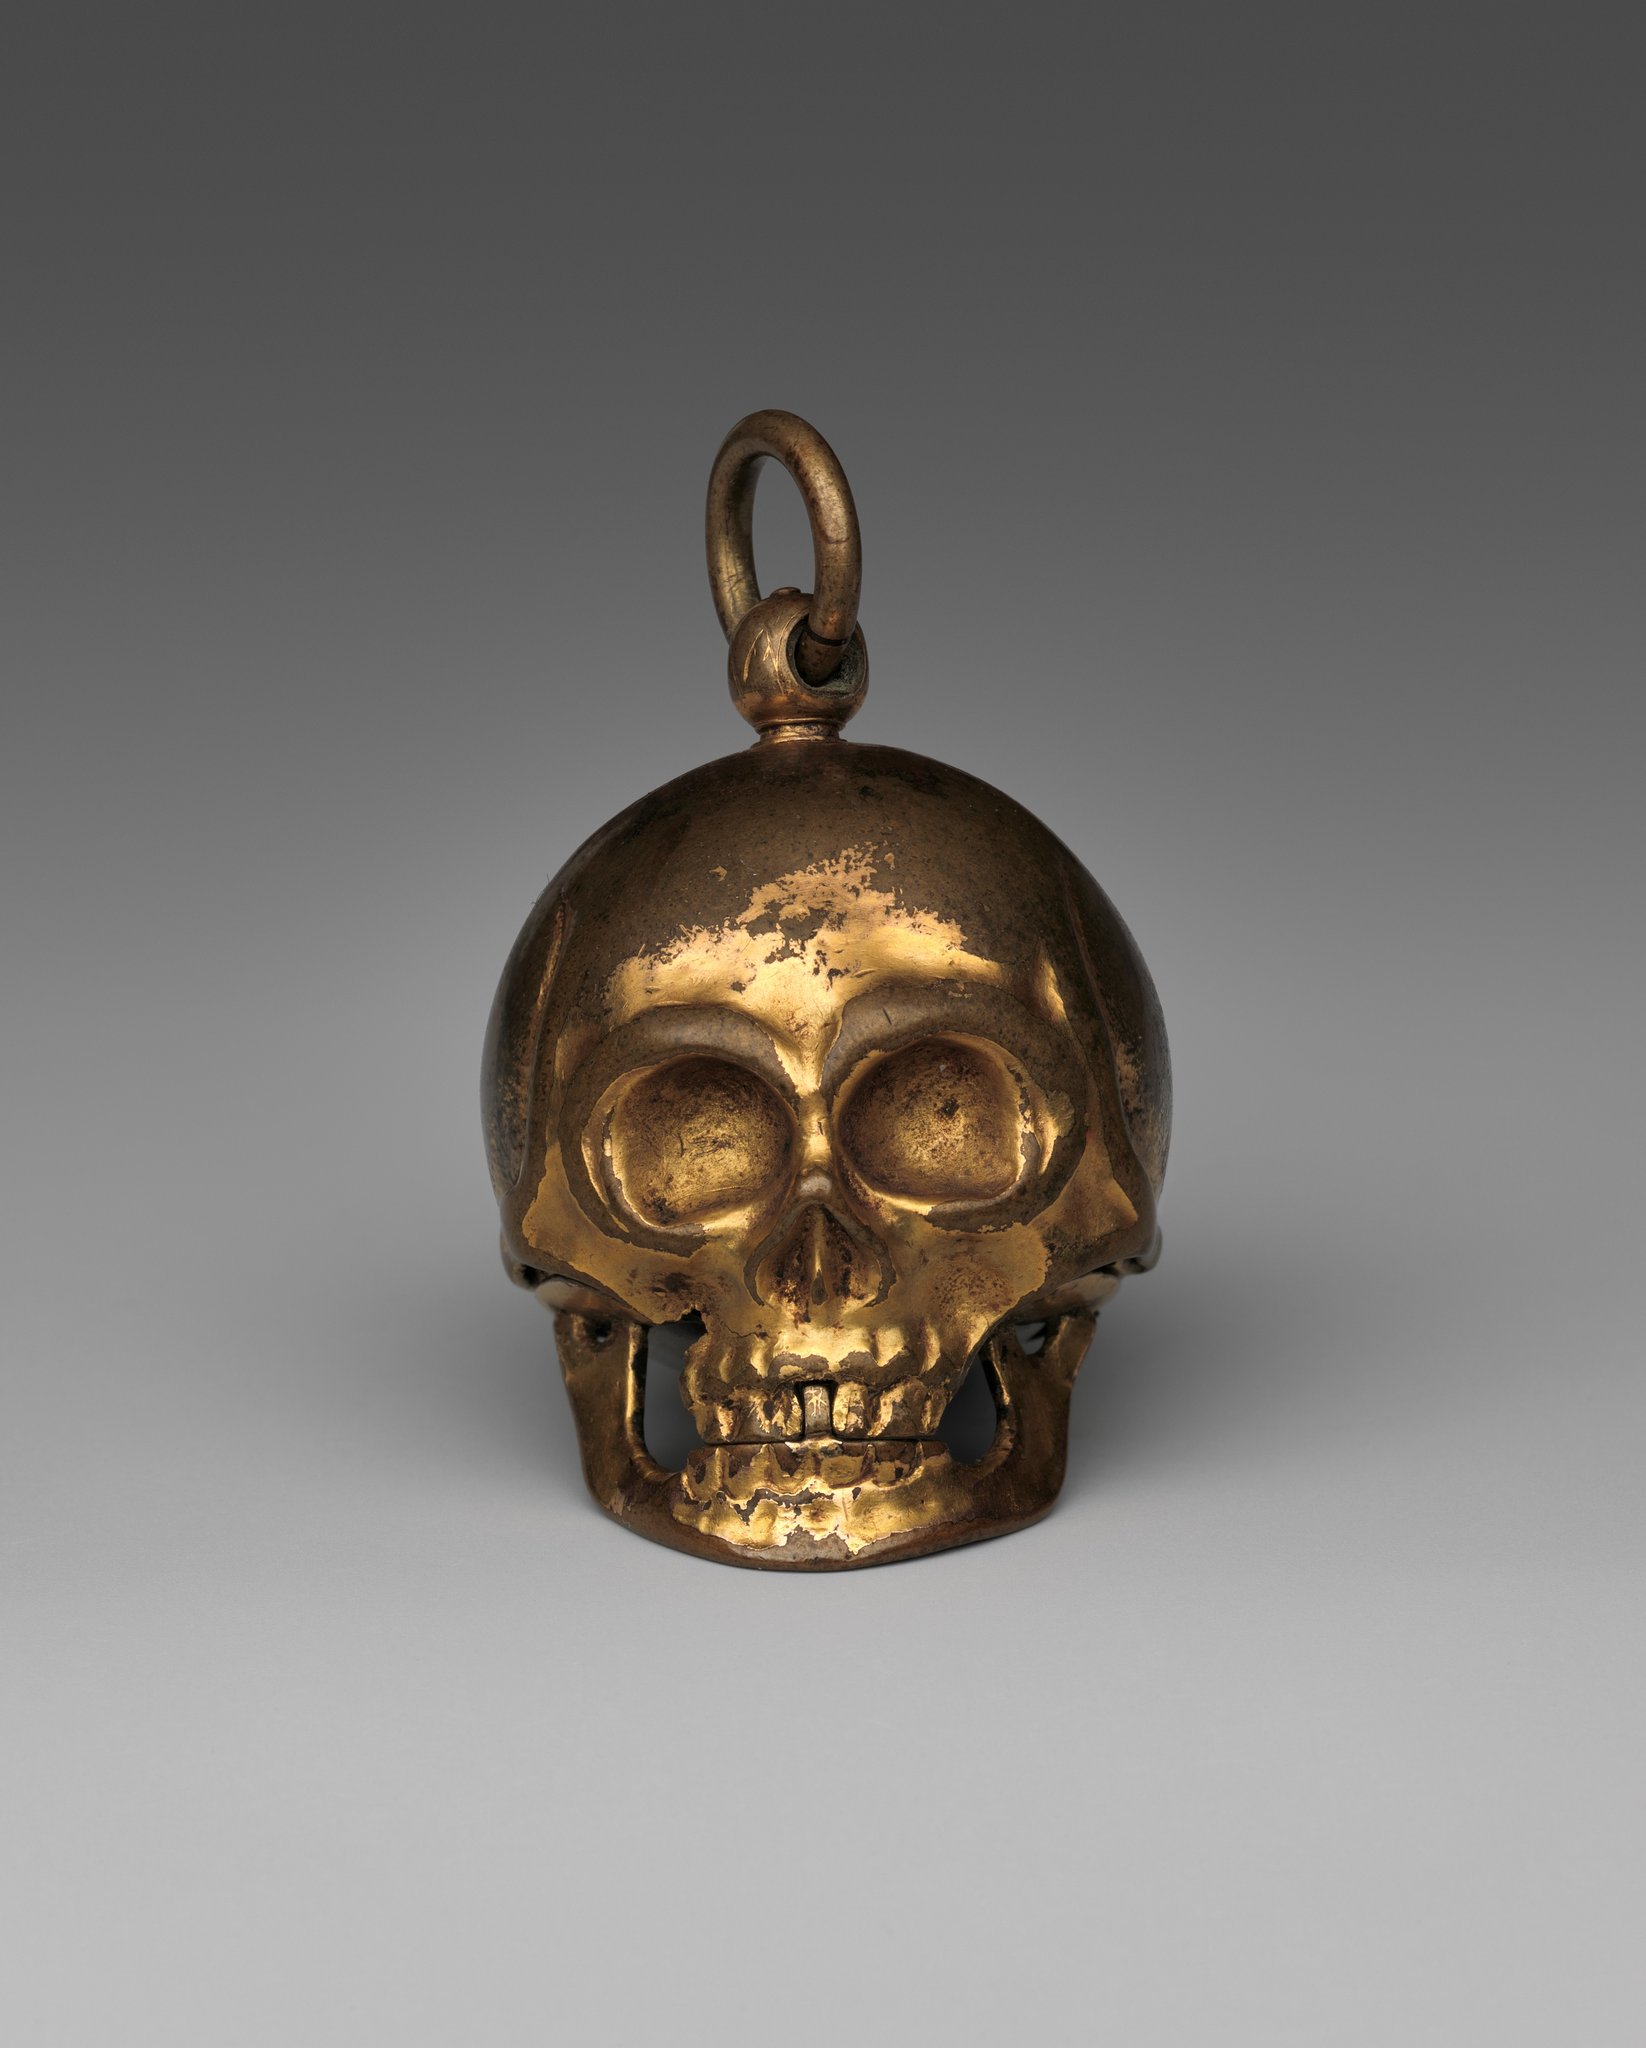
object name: watch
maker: pierre landré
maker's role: maker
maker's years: 1610-1710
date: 1630-1640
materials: brass, gilt brass, steel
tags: skulls